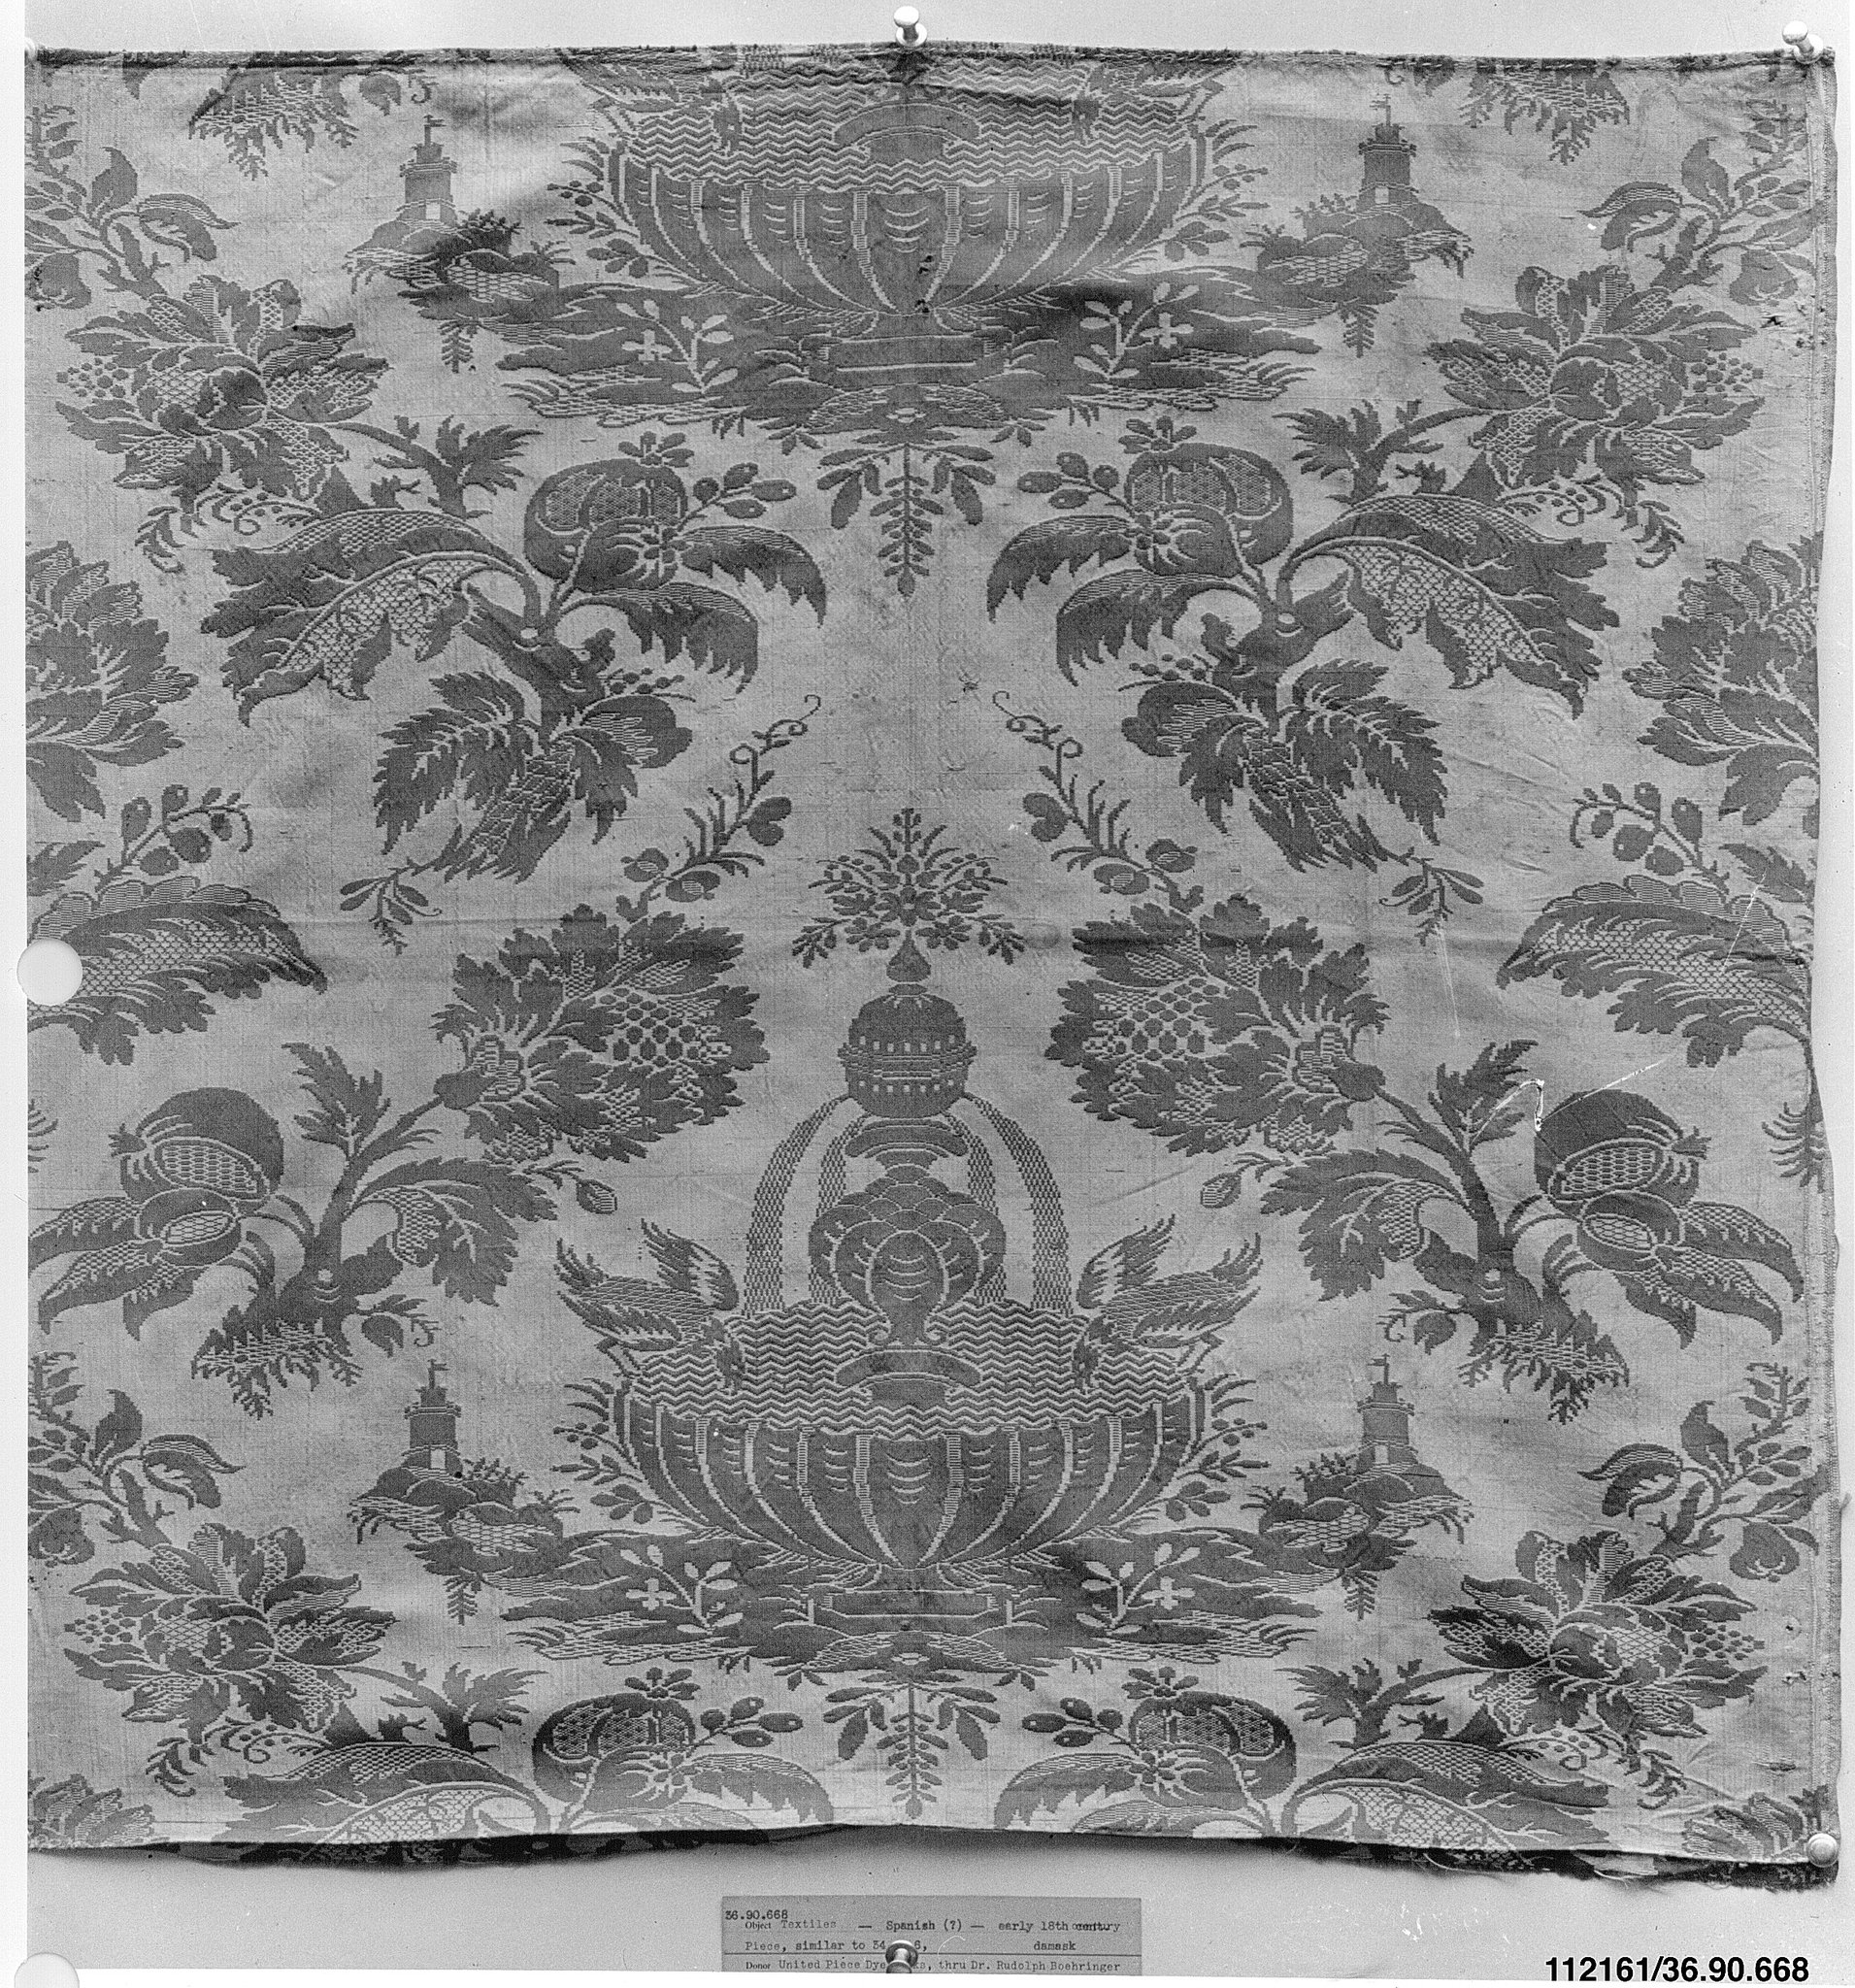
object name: piece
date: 1735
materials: silk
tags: birds,fountains,flowers